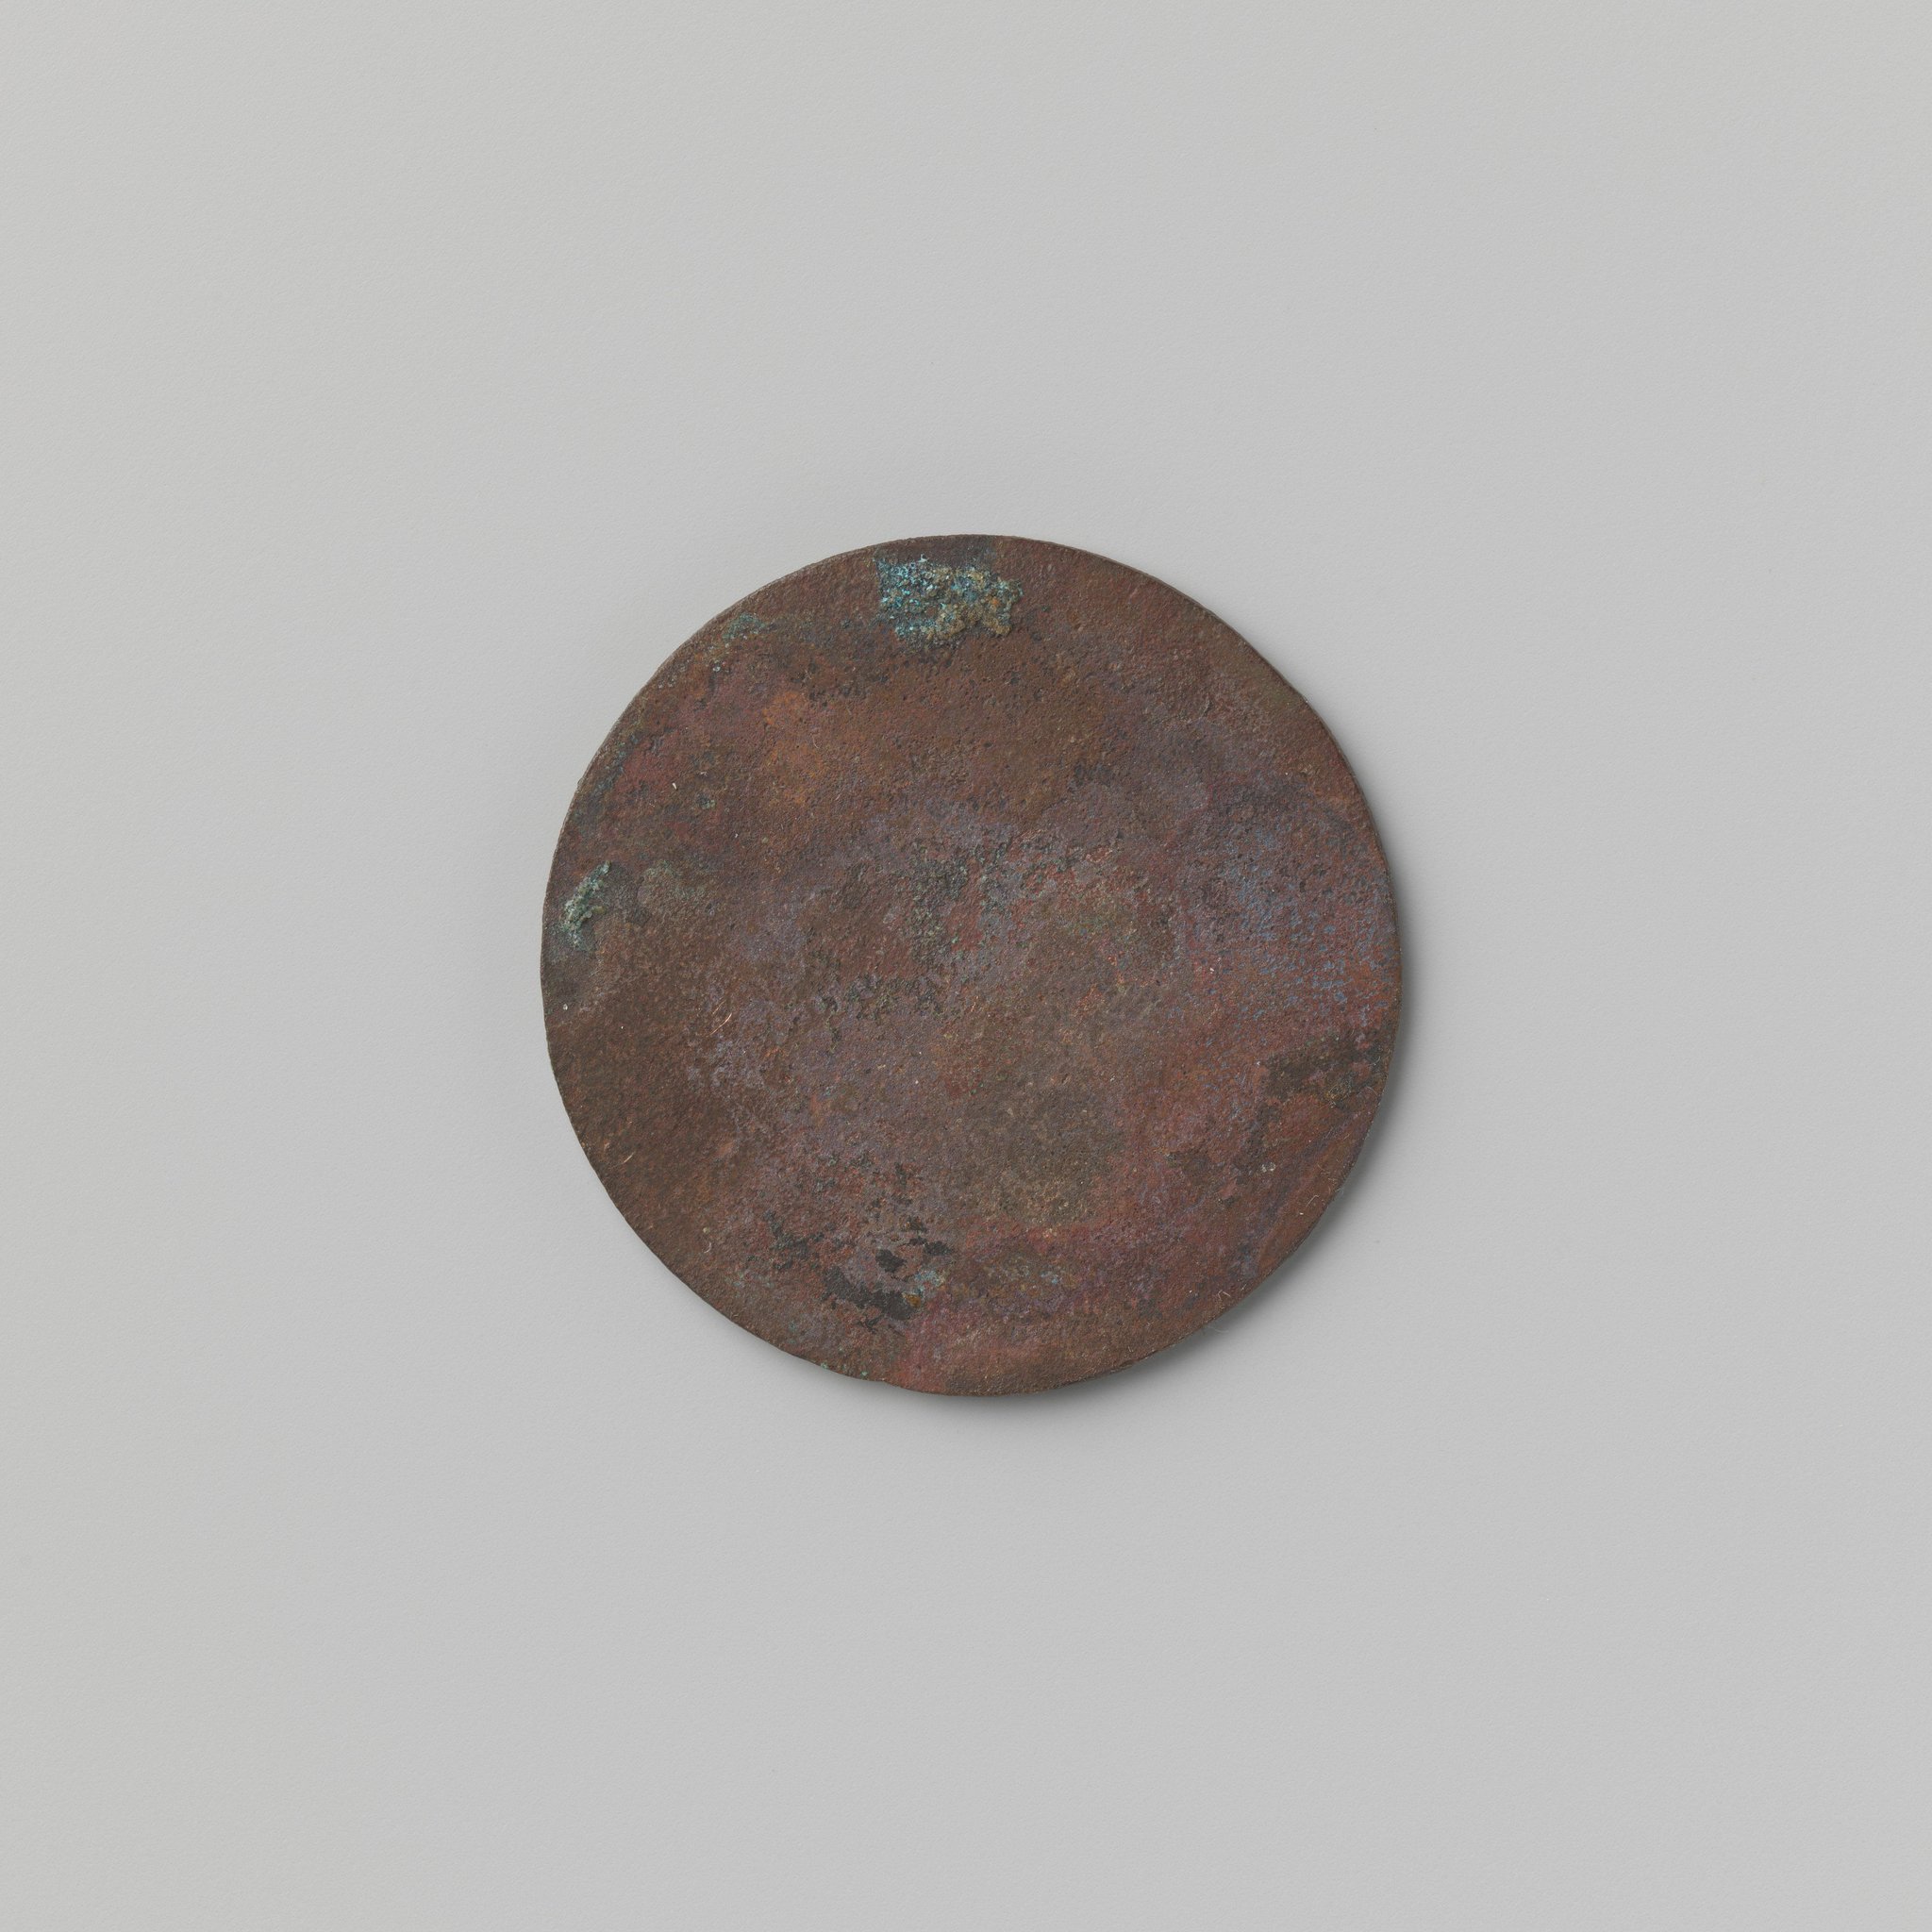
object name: rondel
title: Rondel (ongeslagen muntplaatje)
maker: Anonymous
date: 1700-1800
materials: copper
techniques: striking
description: Rondel, gevonden op het strand van Terschelling, waarschijnlijk van Zweedse oorsprong en in Göteborg of Hamburg ingeladen in een schip dat – op weg naar Lissabon – nabij Terschelling zonk.